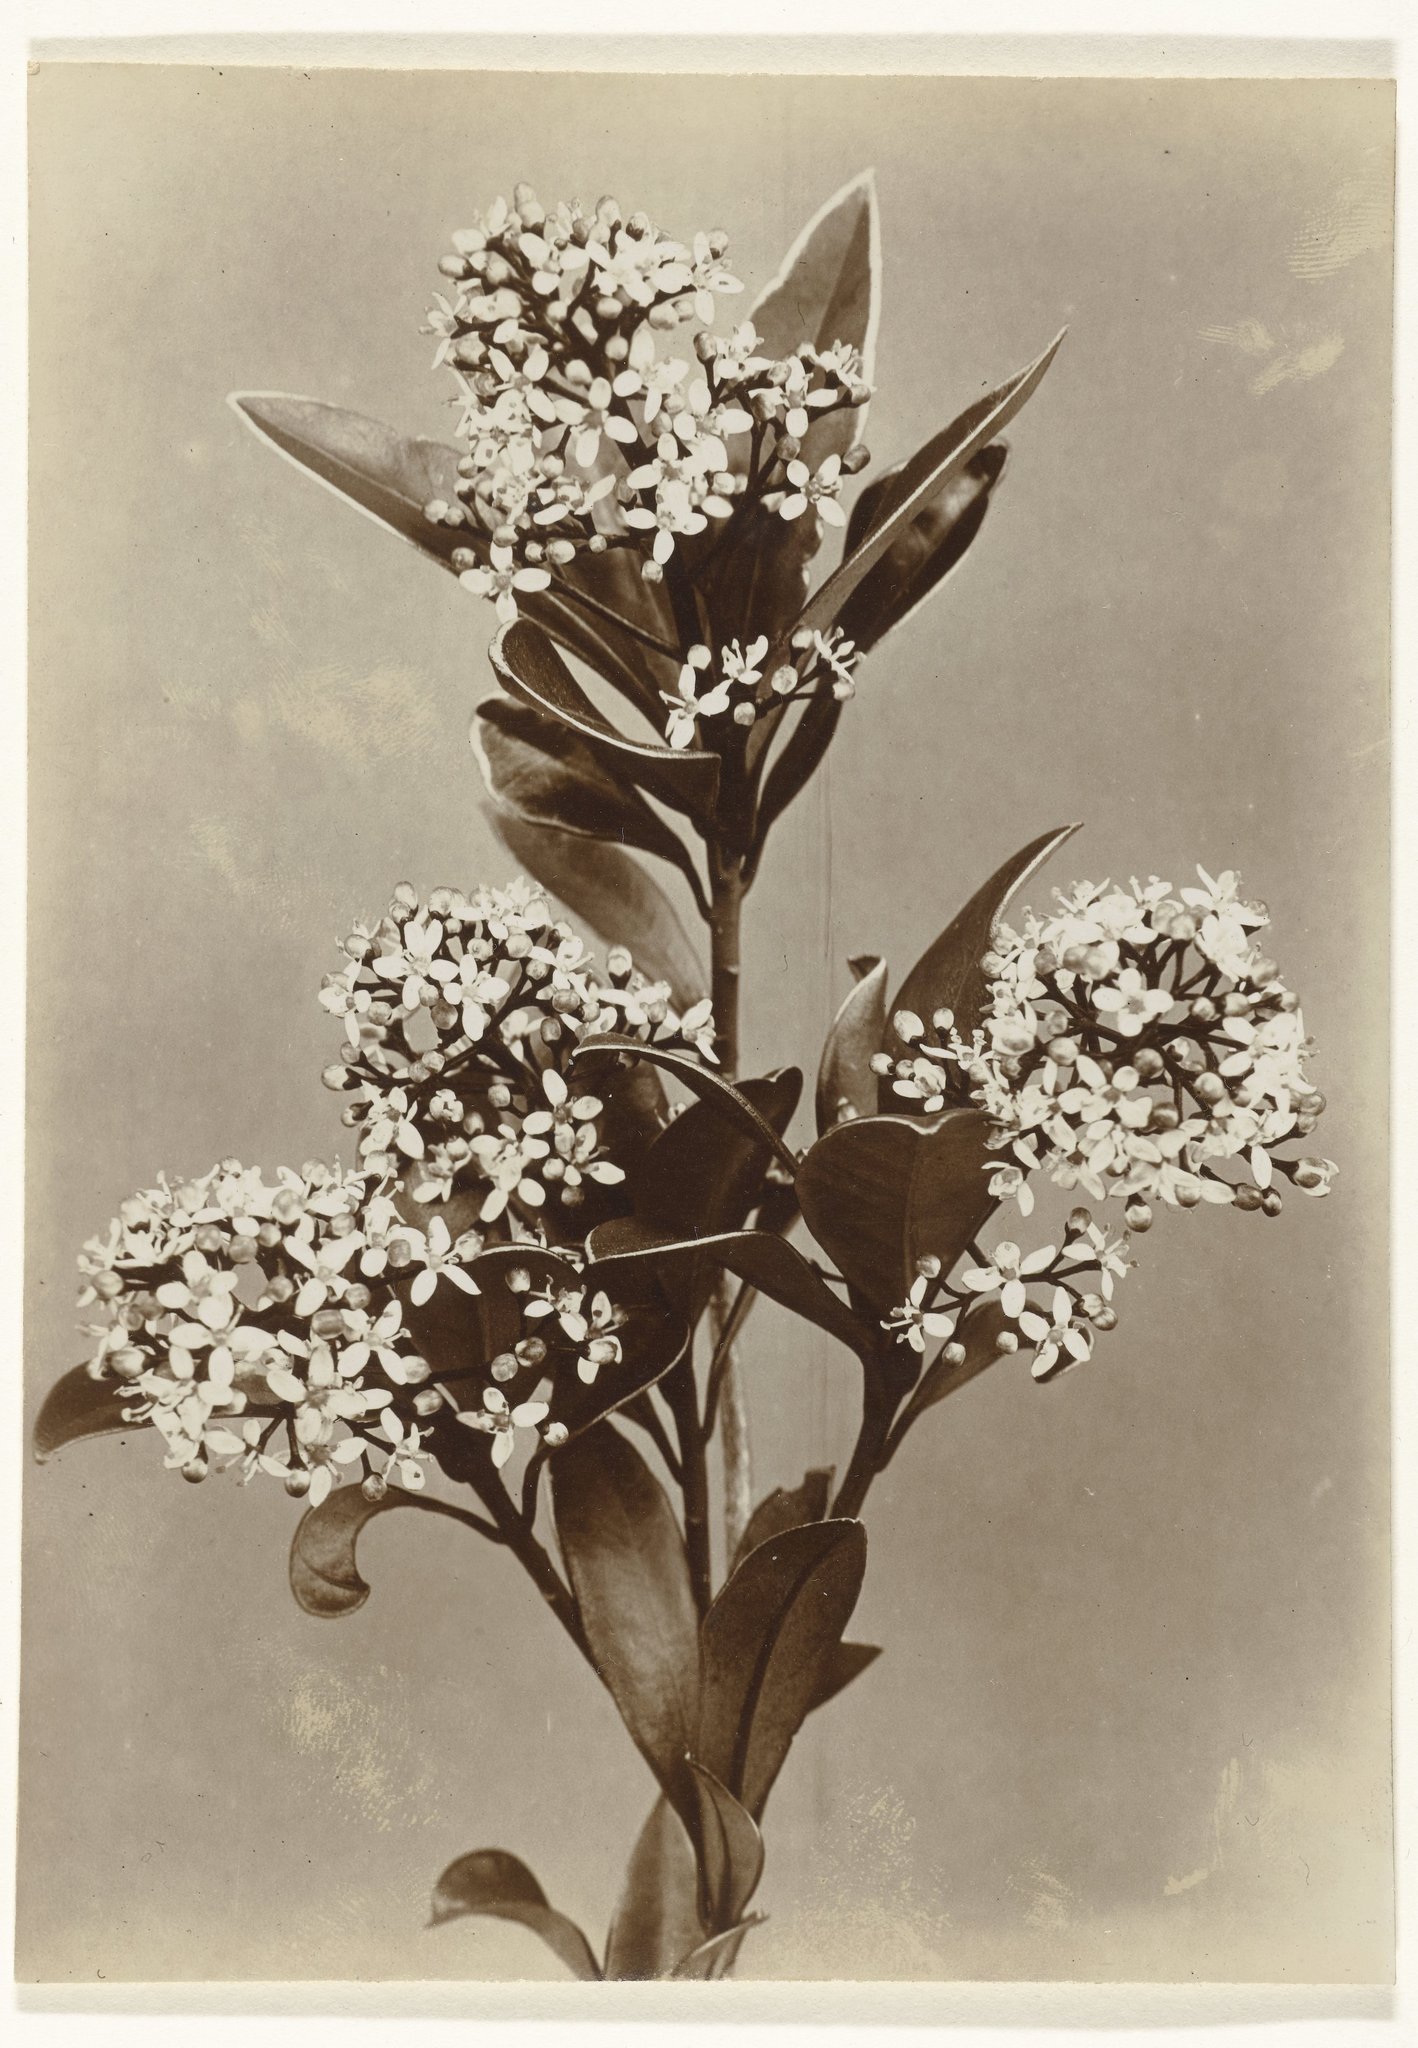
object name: photograph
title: Tak van een skimmia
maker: richard tepe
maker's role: fotograaf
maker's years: 1864-1952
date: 1900-1930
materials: photographic support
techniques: gelatin silver print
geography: netherlands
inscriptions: annotation: ‘Skimmia embellicata [?] / bloeiend’, signature: ‘foto / R. Tepe’